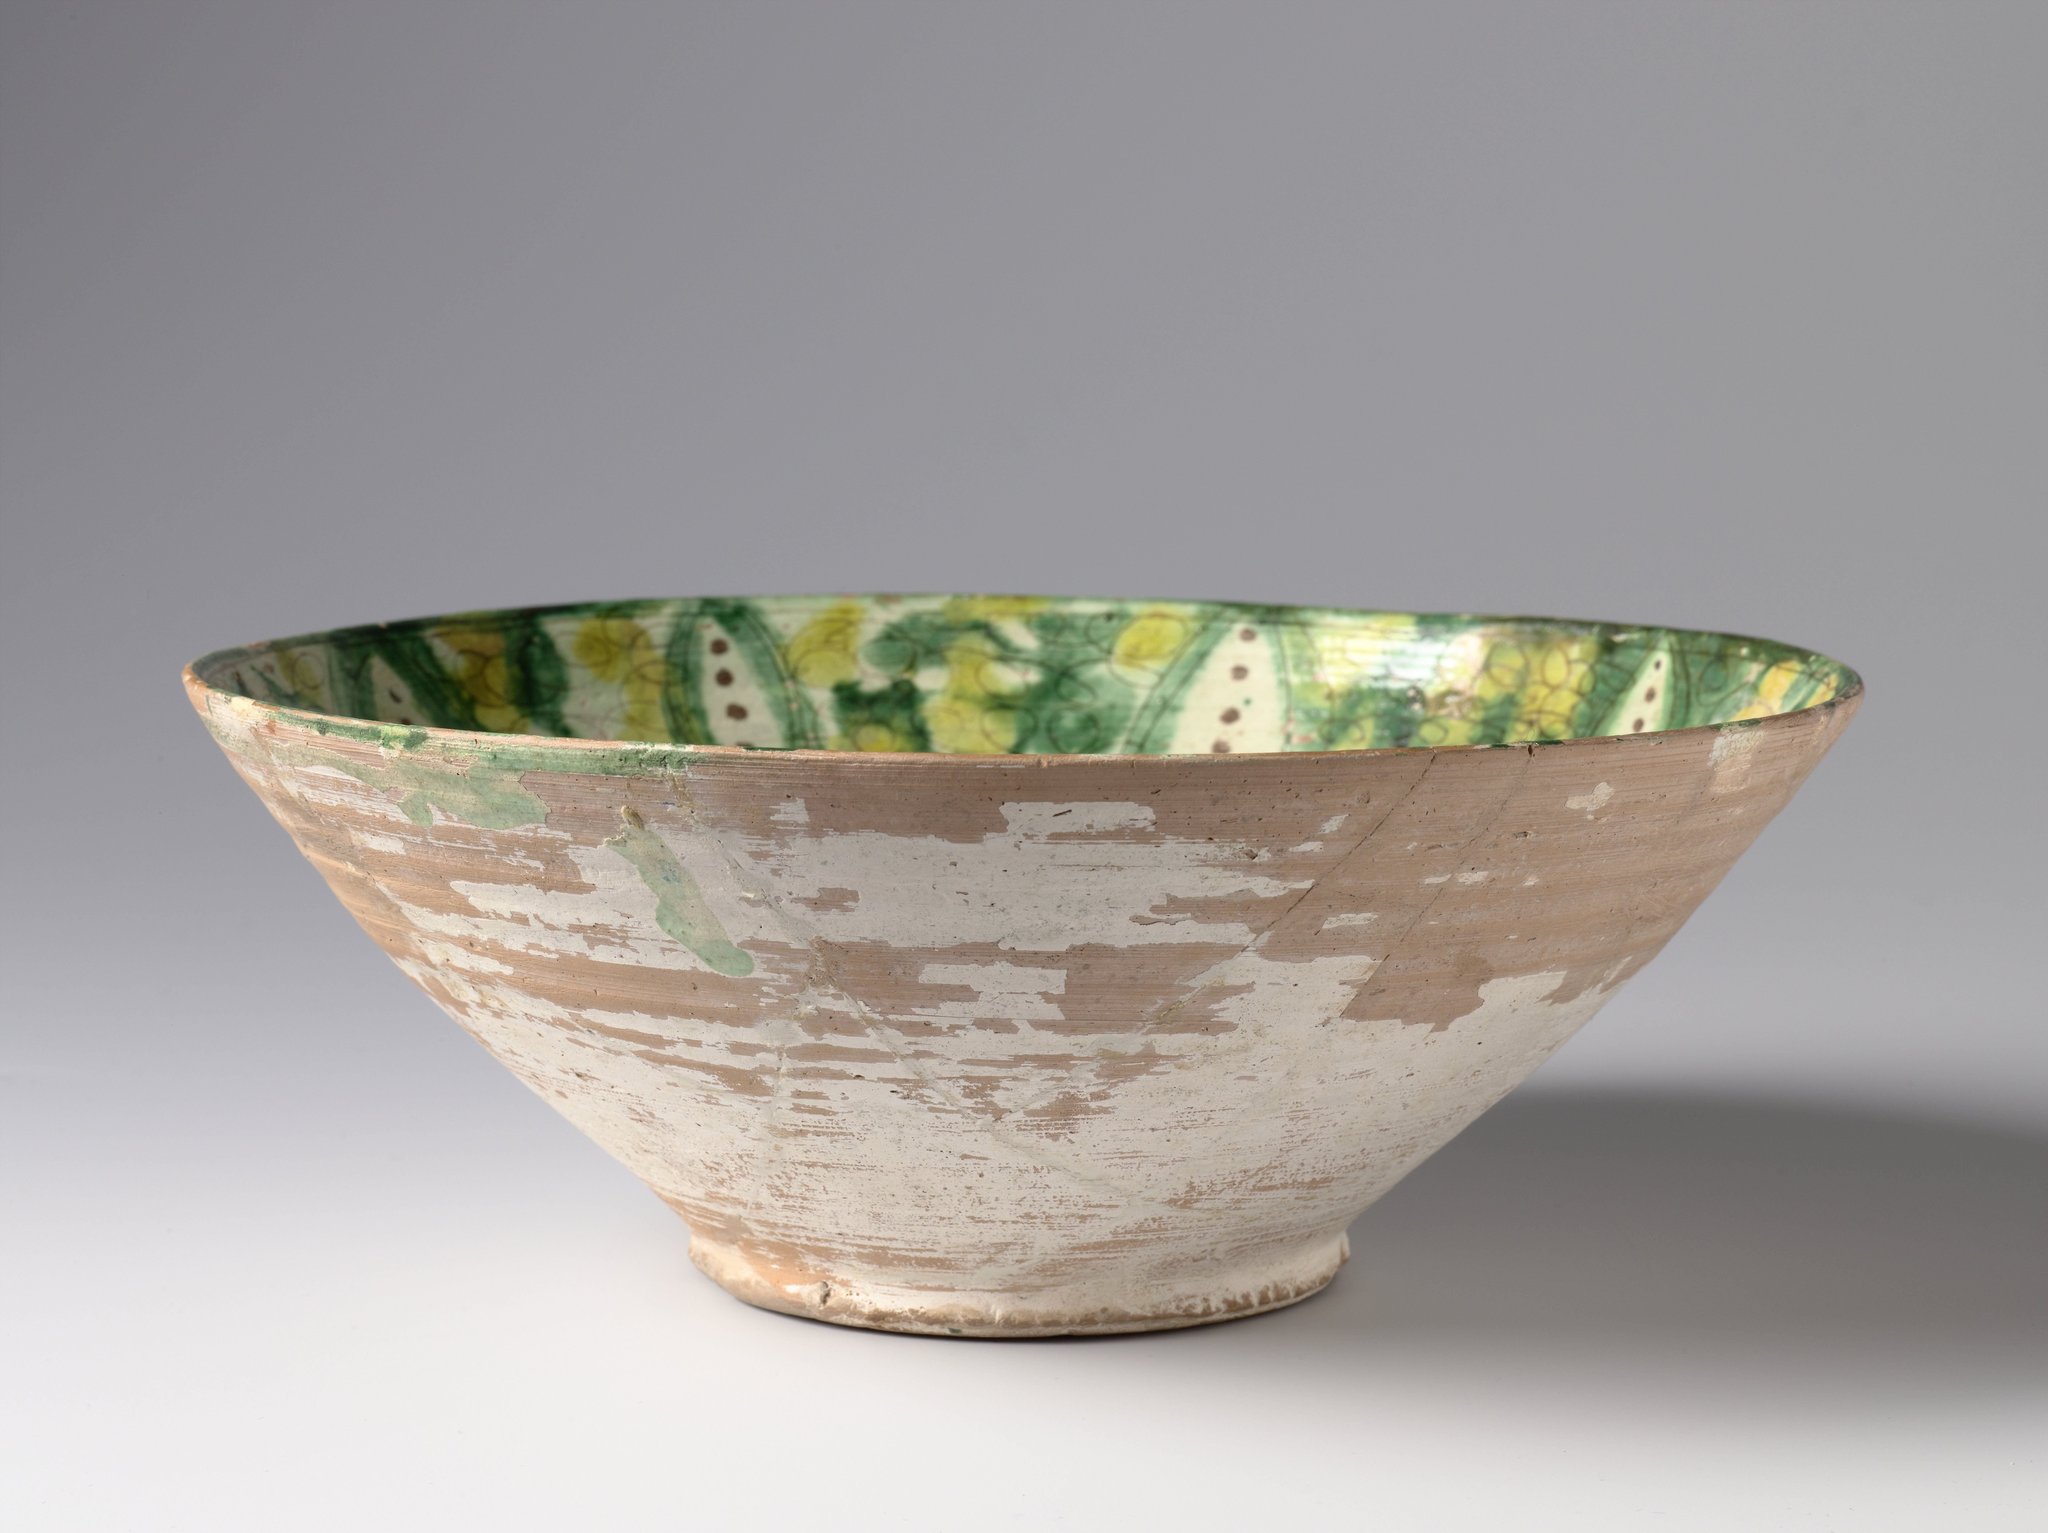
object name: bowl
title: Bowl with foliate motifs and scrolls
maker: Anonymous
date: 900-999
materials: earthenware, glaze, paint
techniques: firing, turning, vitrification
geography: nishapur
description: Kom van aardewerk gedecoreerd met polychrome versiering van groene en gele loodglazuren en mangaanbruine slib naast sgraffito bladmotieven en krulwerk op engobe van witte slib.